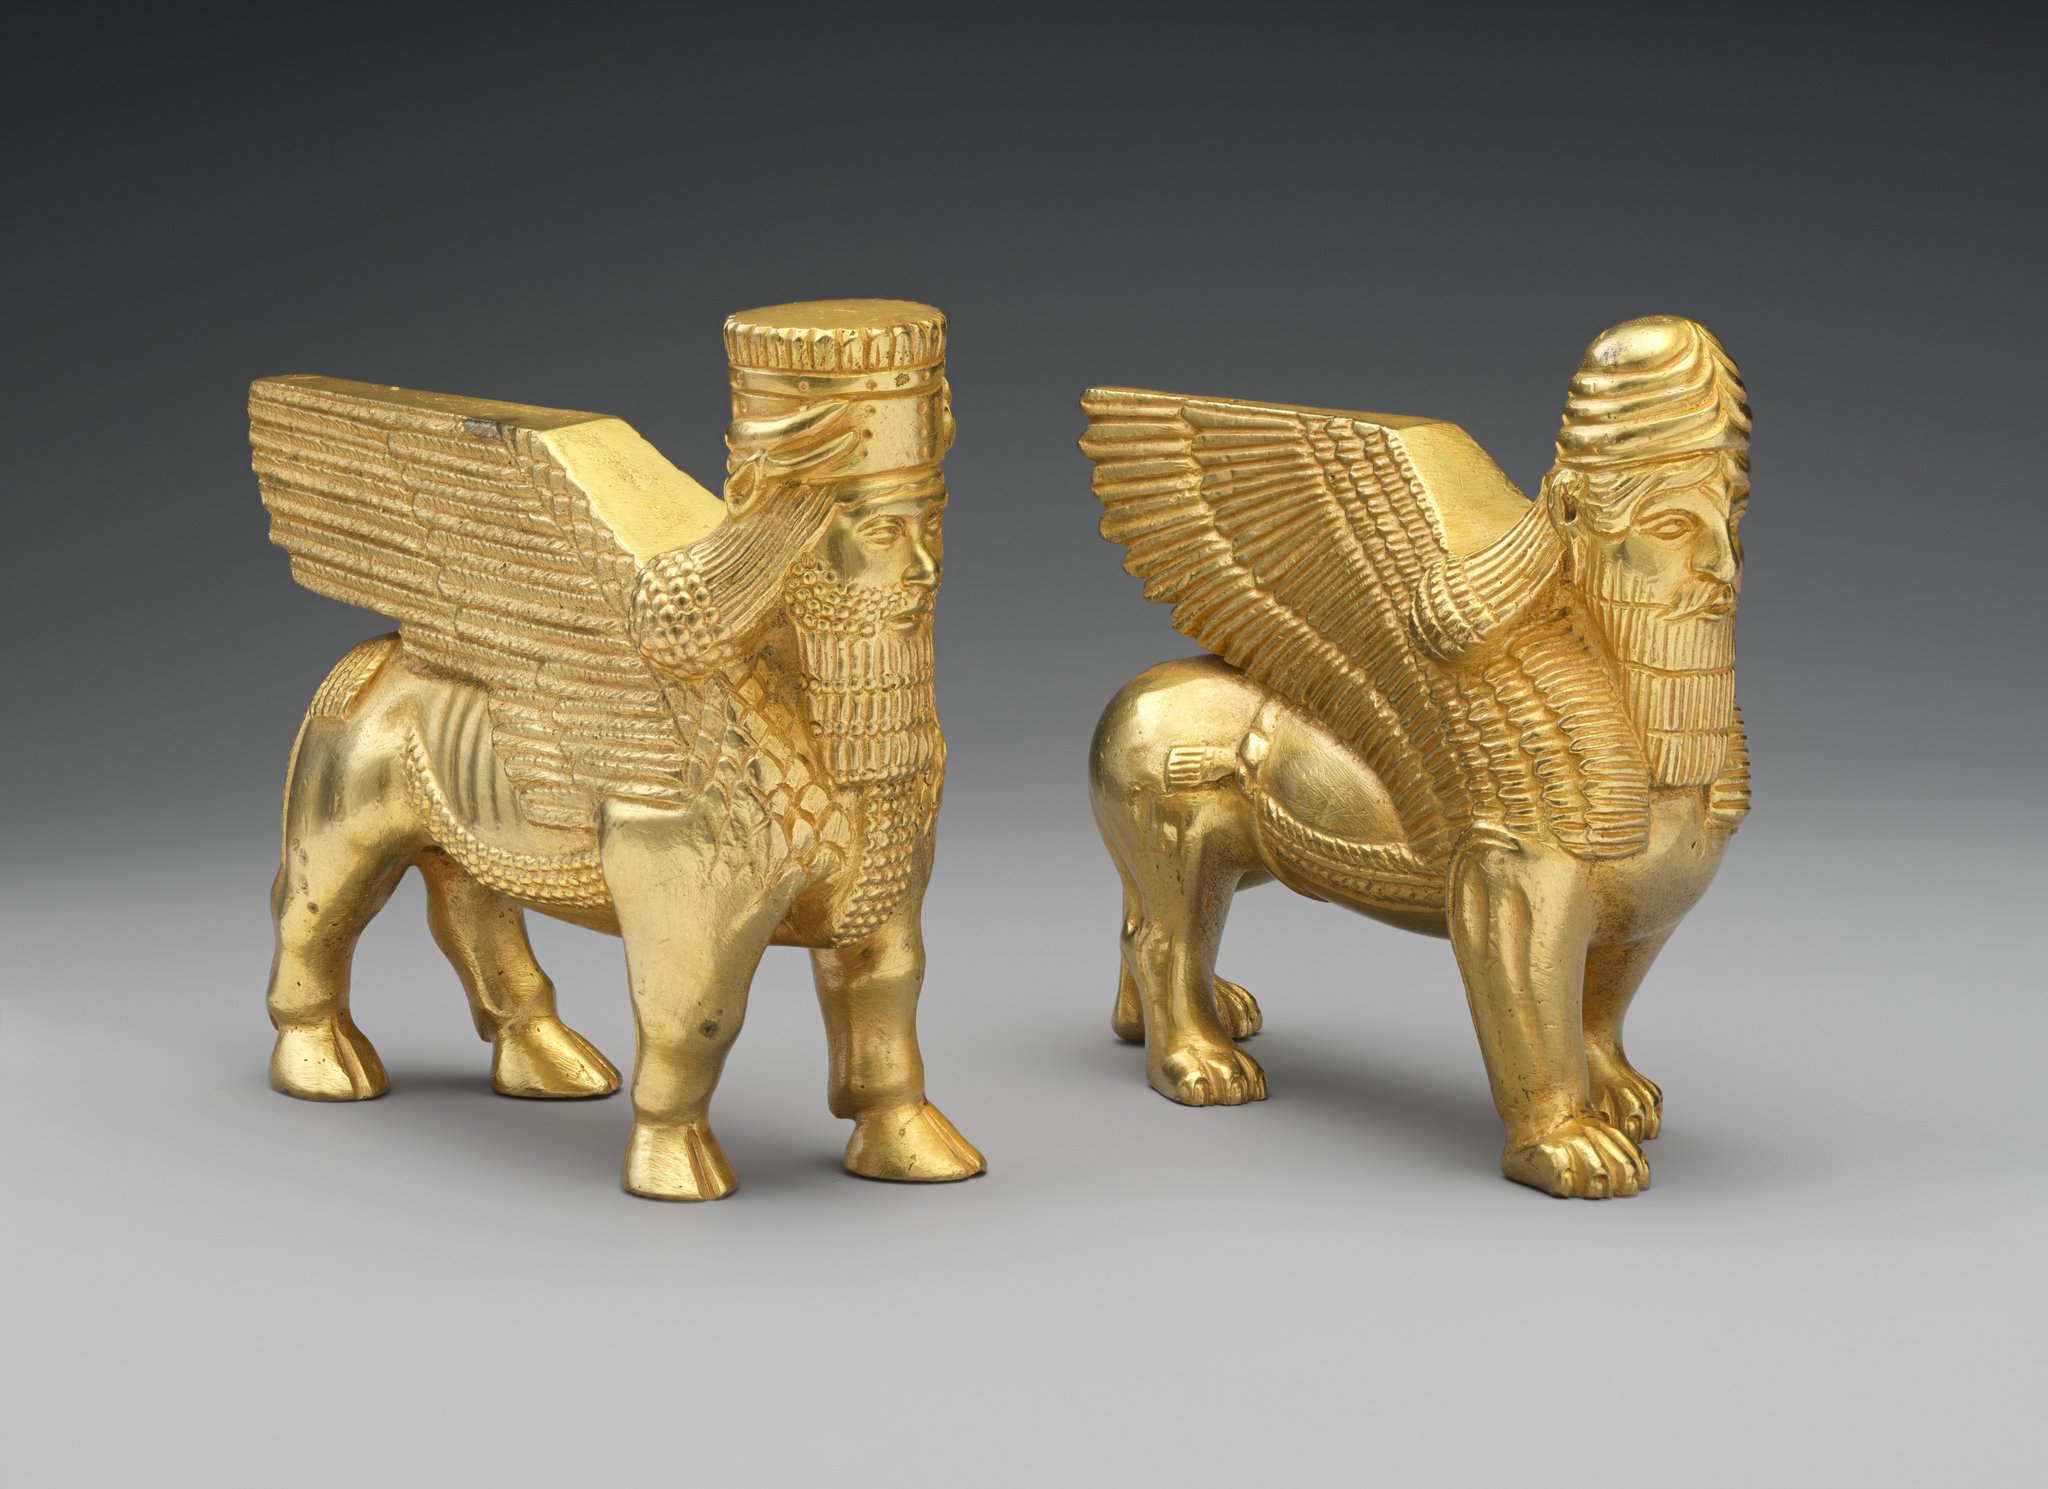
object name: winged bull and lion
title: Human-headed winged bull and lion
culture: british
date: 1850-1900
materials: gilt bronze